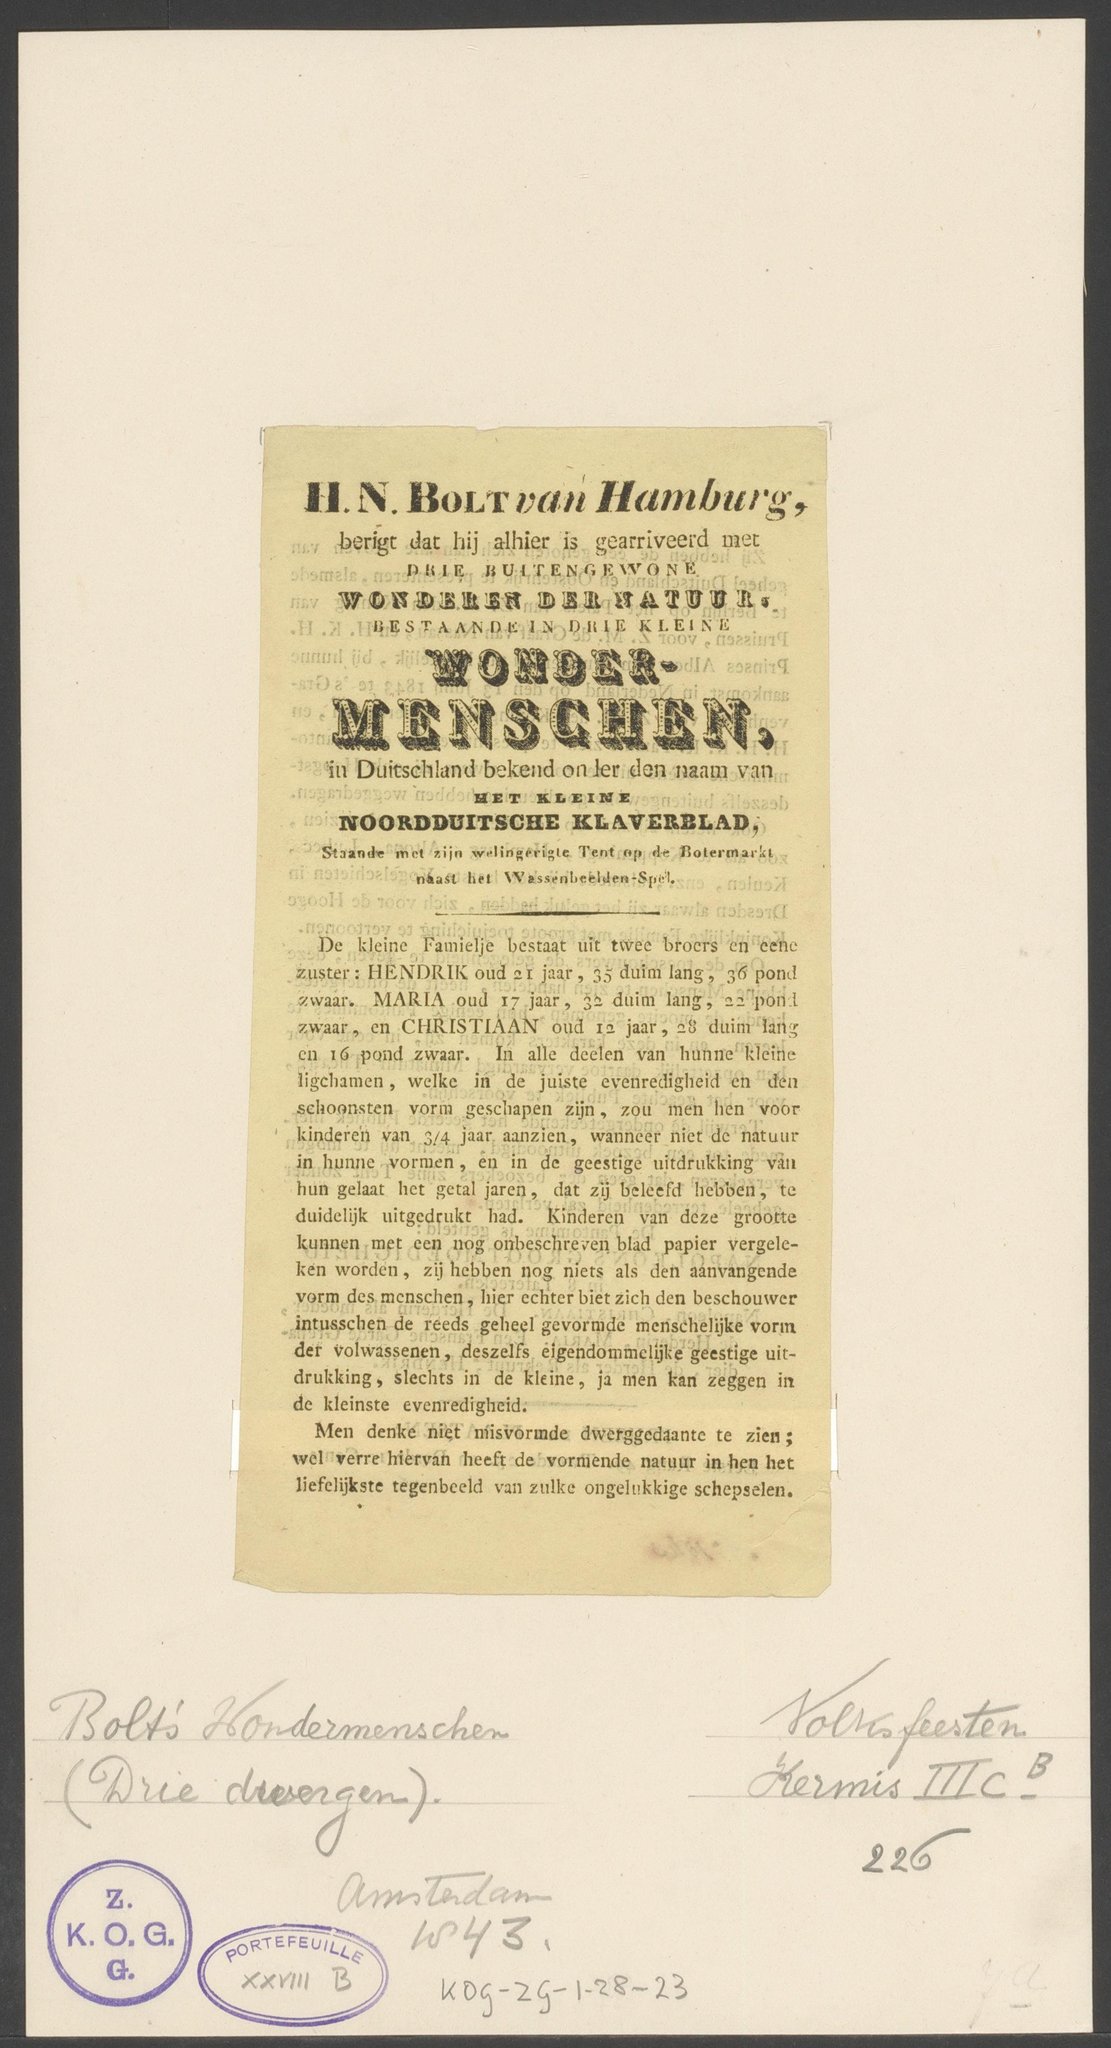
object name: text sheet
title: Aanprijzing van de mensen die H.N. Bolt tentoonstelt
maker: Anonymous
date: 1843-1845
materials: paper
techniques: letterpress printing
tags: human monstrosities ~ freak show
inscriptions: stamp, collector's mark: Lugt 1641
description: Aanprijzing van de mensen die H.N. Bolt uit Hamburg tentoonstelt. Hij reist rond met drie kinderen, de kinderen werden tentoongesteld omdat zij klein zijn. Hij was in 1843 in Amsterdam. Onderwerpsrubrieken binnen de Atlas Zeden en Gewoonten: Zeden en Gewoonten in Engeren Zin. Volksleven. Volksfeesten. Kermistypen, wondermenschen en dergelijken.